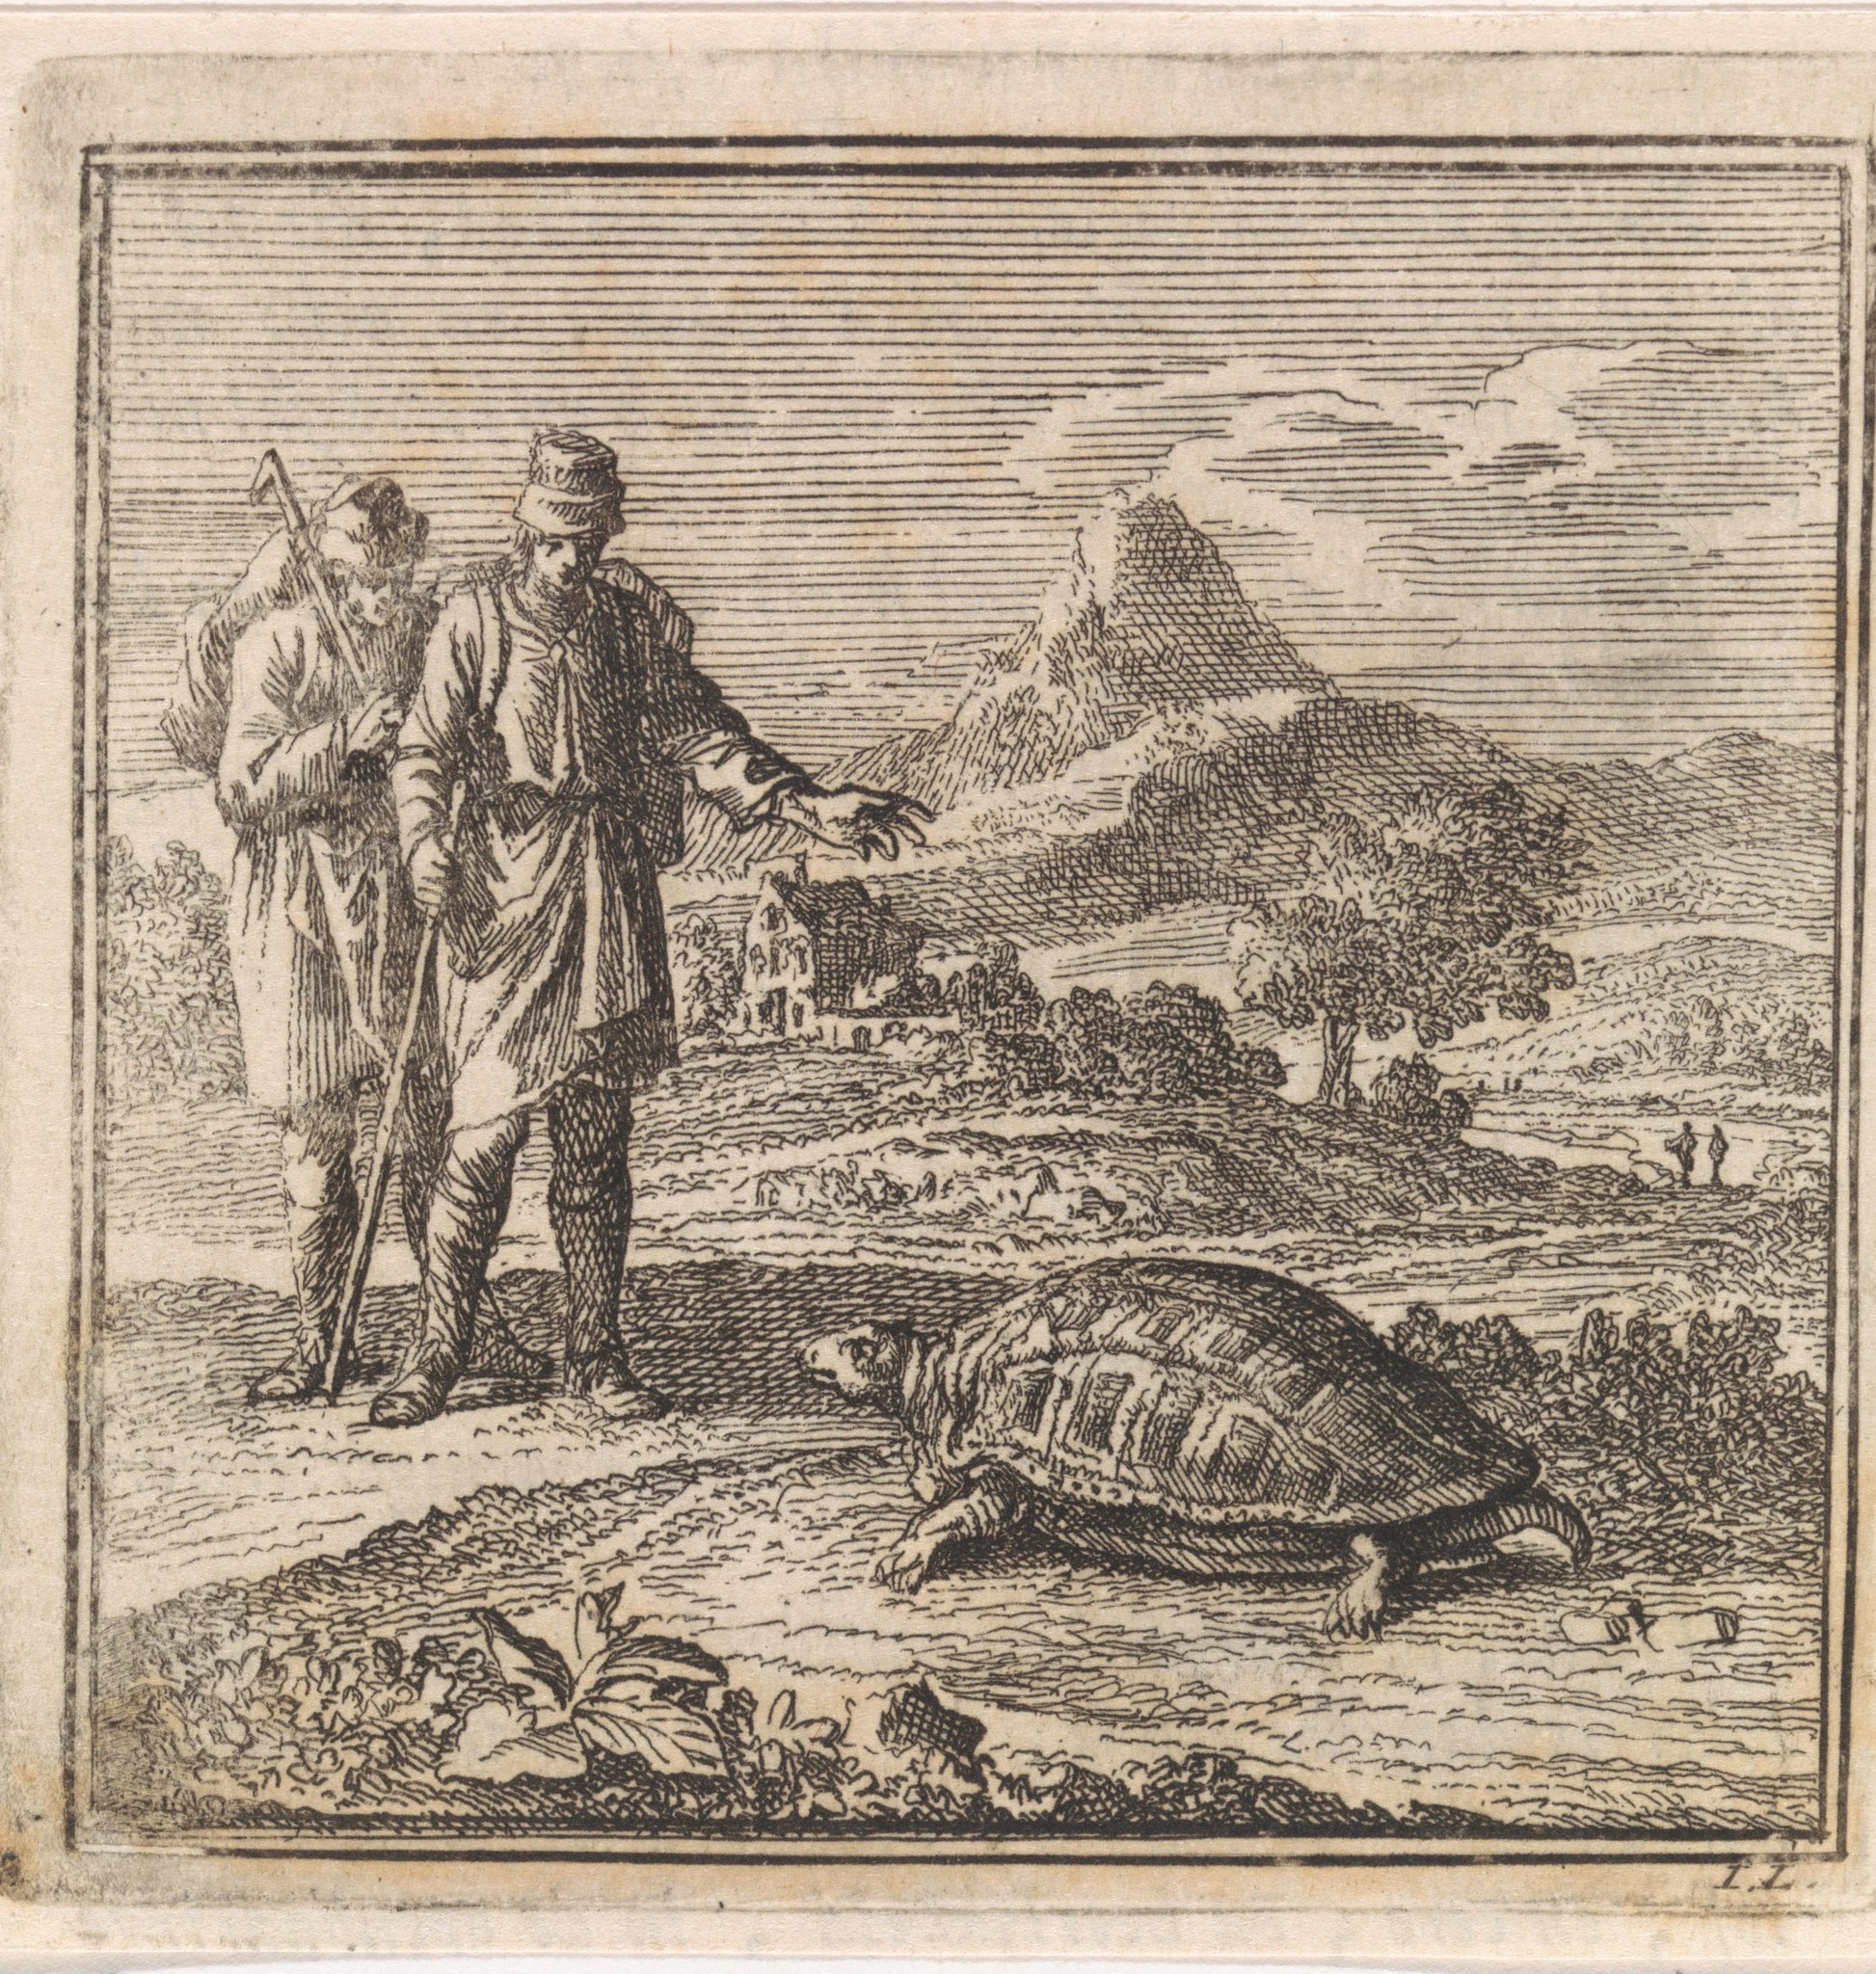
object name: print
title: Twee reizigers bewonderen een schildpad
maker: jan luyken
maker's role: draughtsman, print maker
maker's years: 1649-1712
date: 1711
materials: paper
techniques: etching, letterpress printing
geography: amsterdam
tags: landscapes, tortoises, turtles, 'en route', traveller under way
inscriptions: collector's mark: Lugt 2228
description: Illustratie voor: Luyken, Jan. De Bykorf des Gemoeds. Amsterdam: Pieter Arentsz. II (wed.) en Cornelis van der Sys, 1711, p. 26.